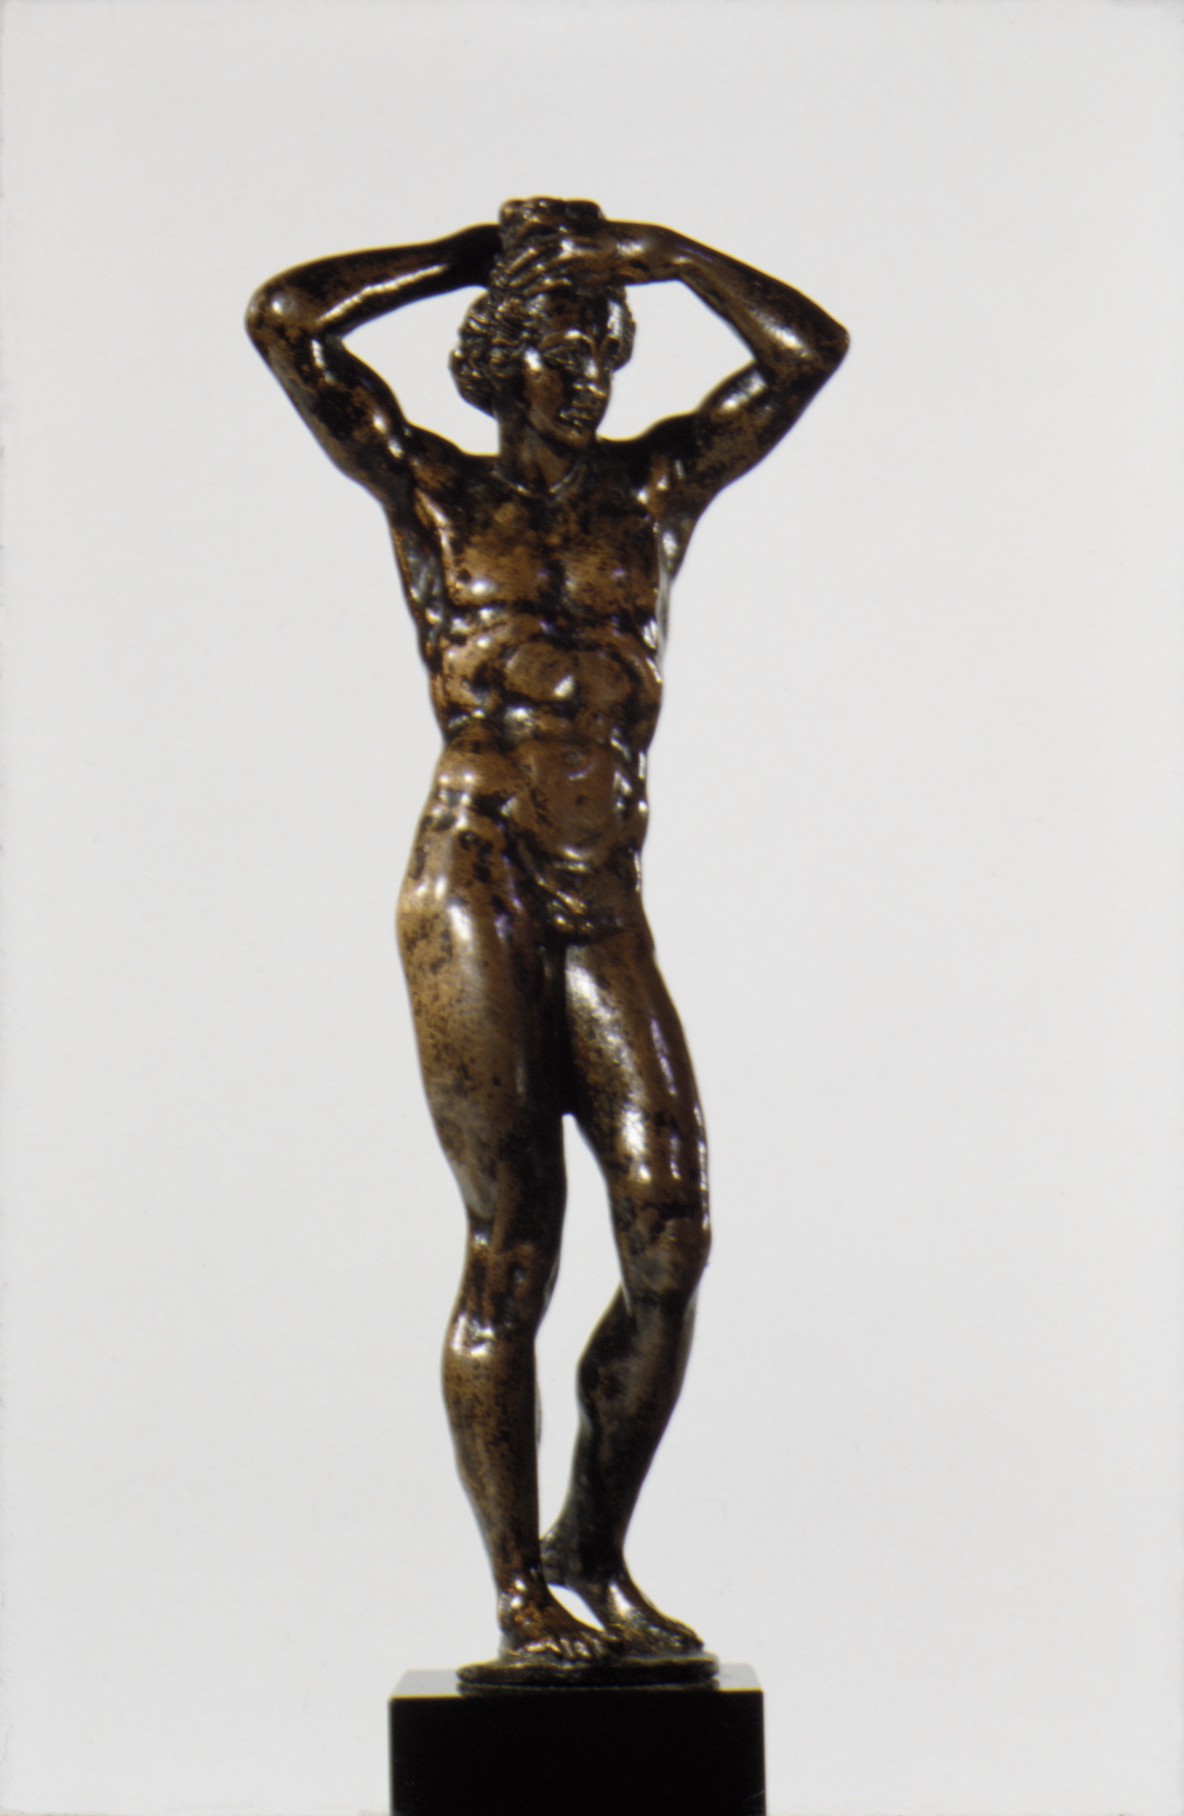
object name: statuette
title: Male nude supporting a wreath on his head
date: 1567-1633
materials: bronze, lacquer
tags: male nudes,wreaths